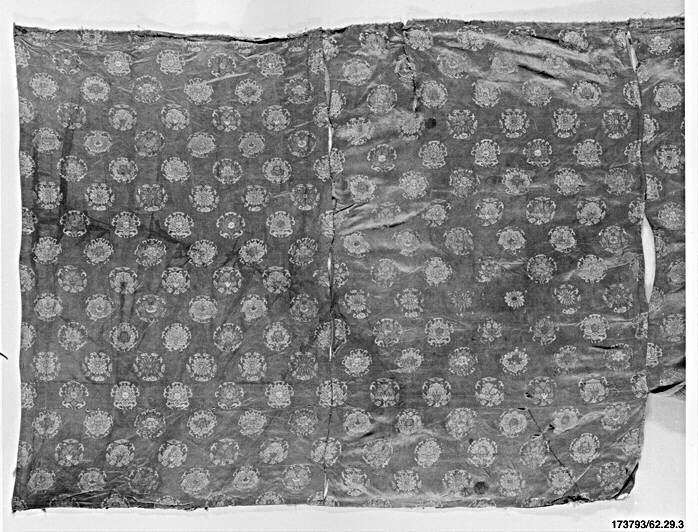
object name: panel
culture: chinese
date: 1567-1633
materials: silk